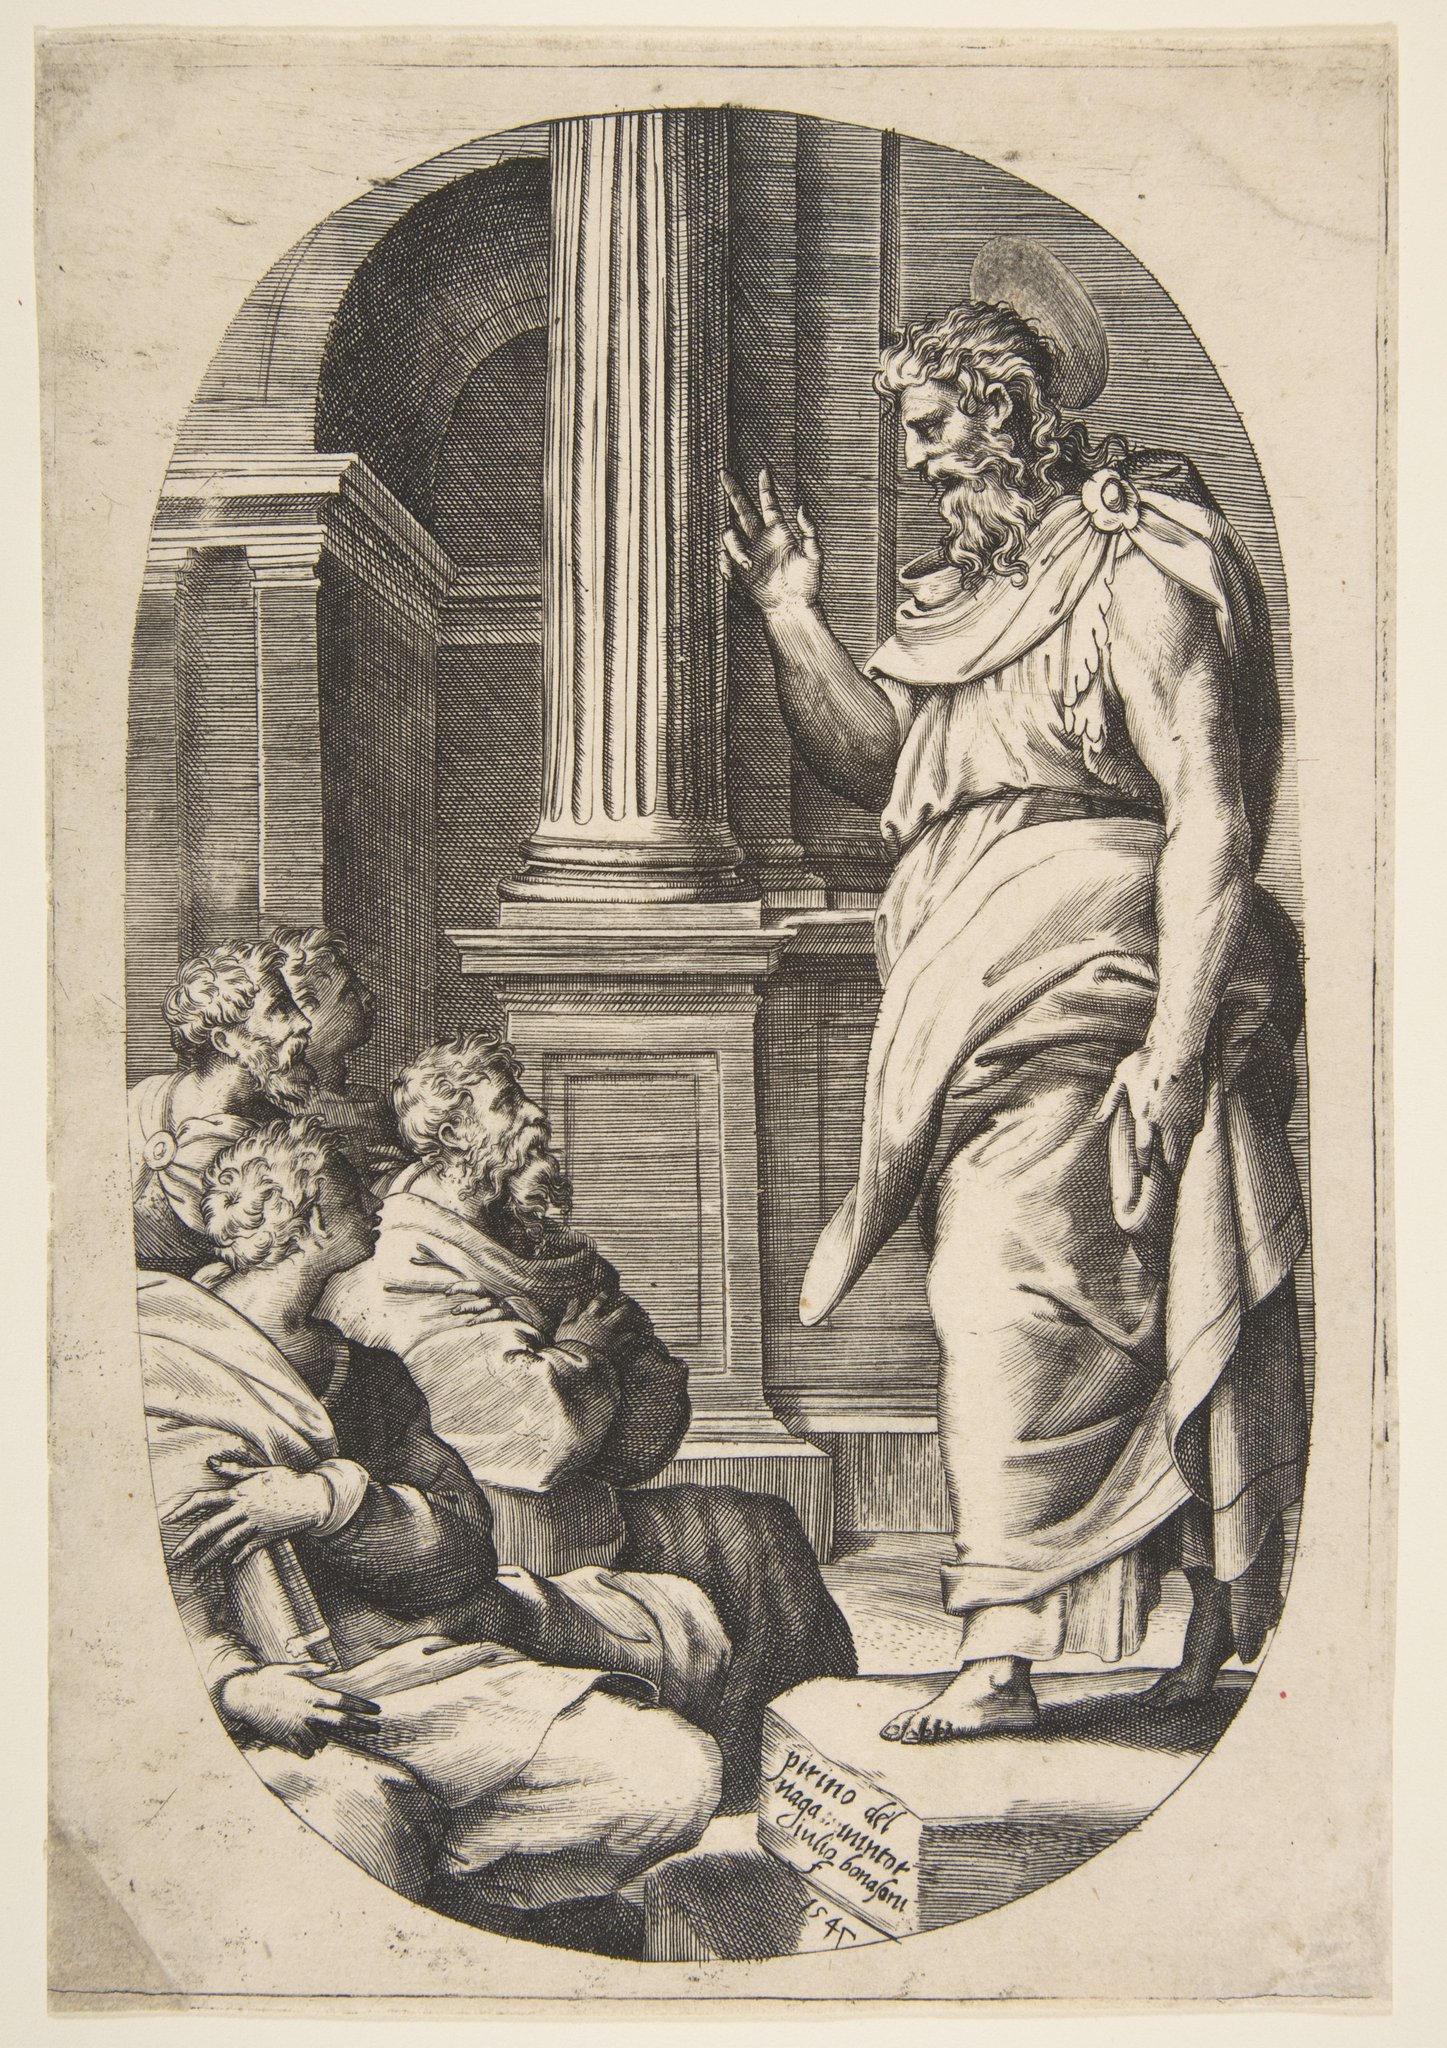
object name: print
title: Saint Paul Preaching, an oval composition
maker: giulio bonasone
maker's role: artist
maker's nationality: italian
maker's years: 1510-1576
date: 1547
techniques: engraving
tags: men,saint paul